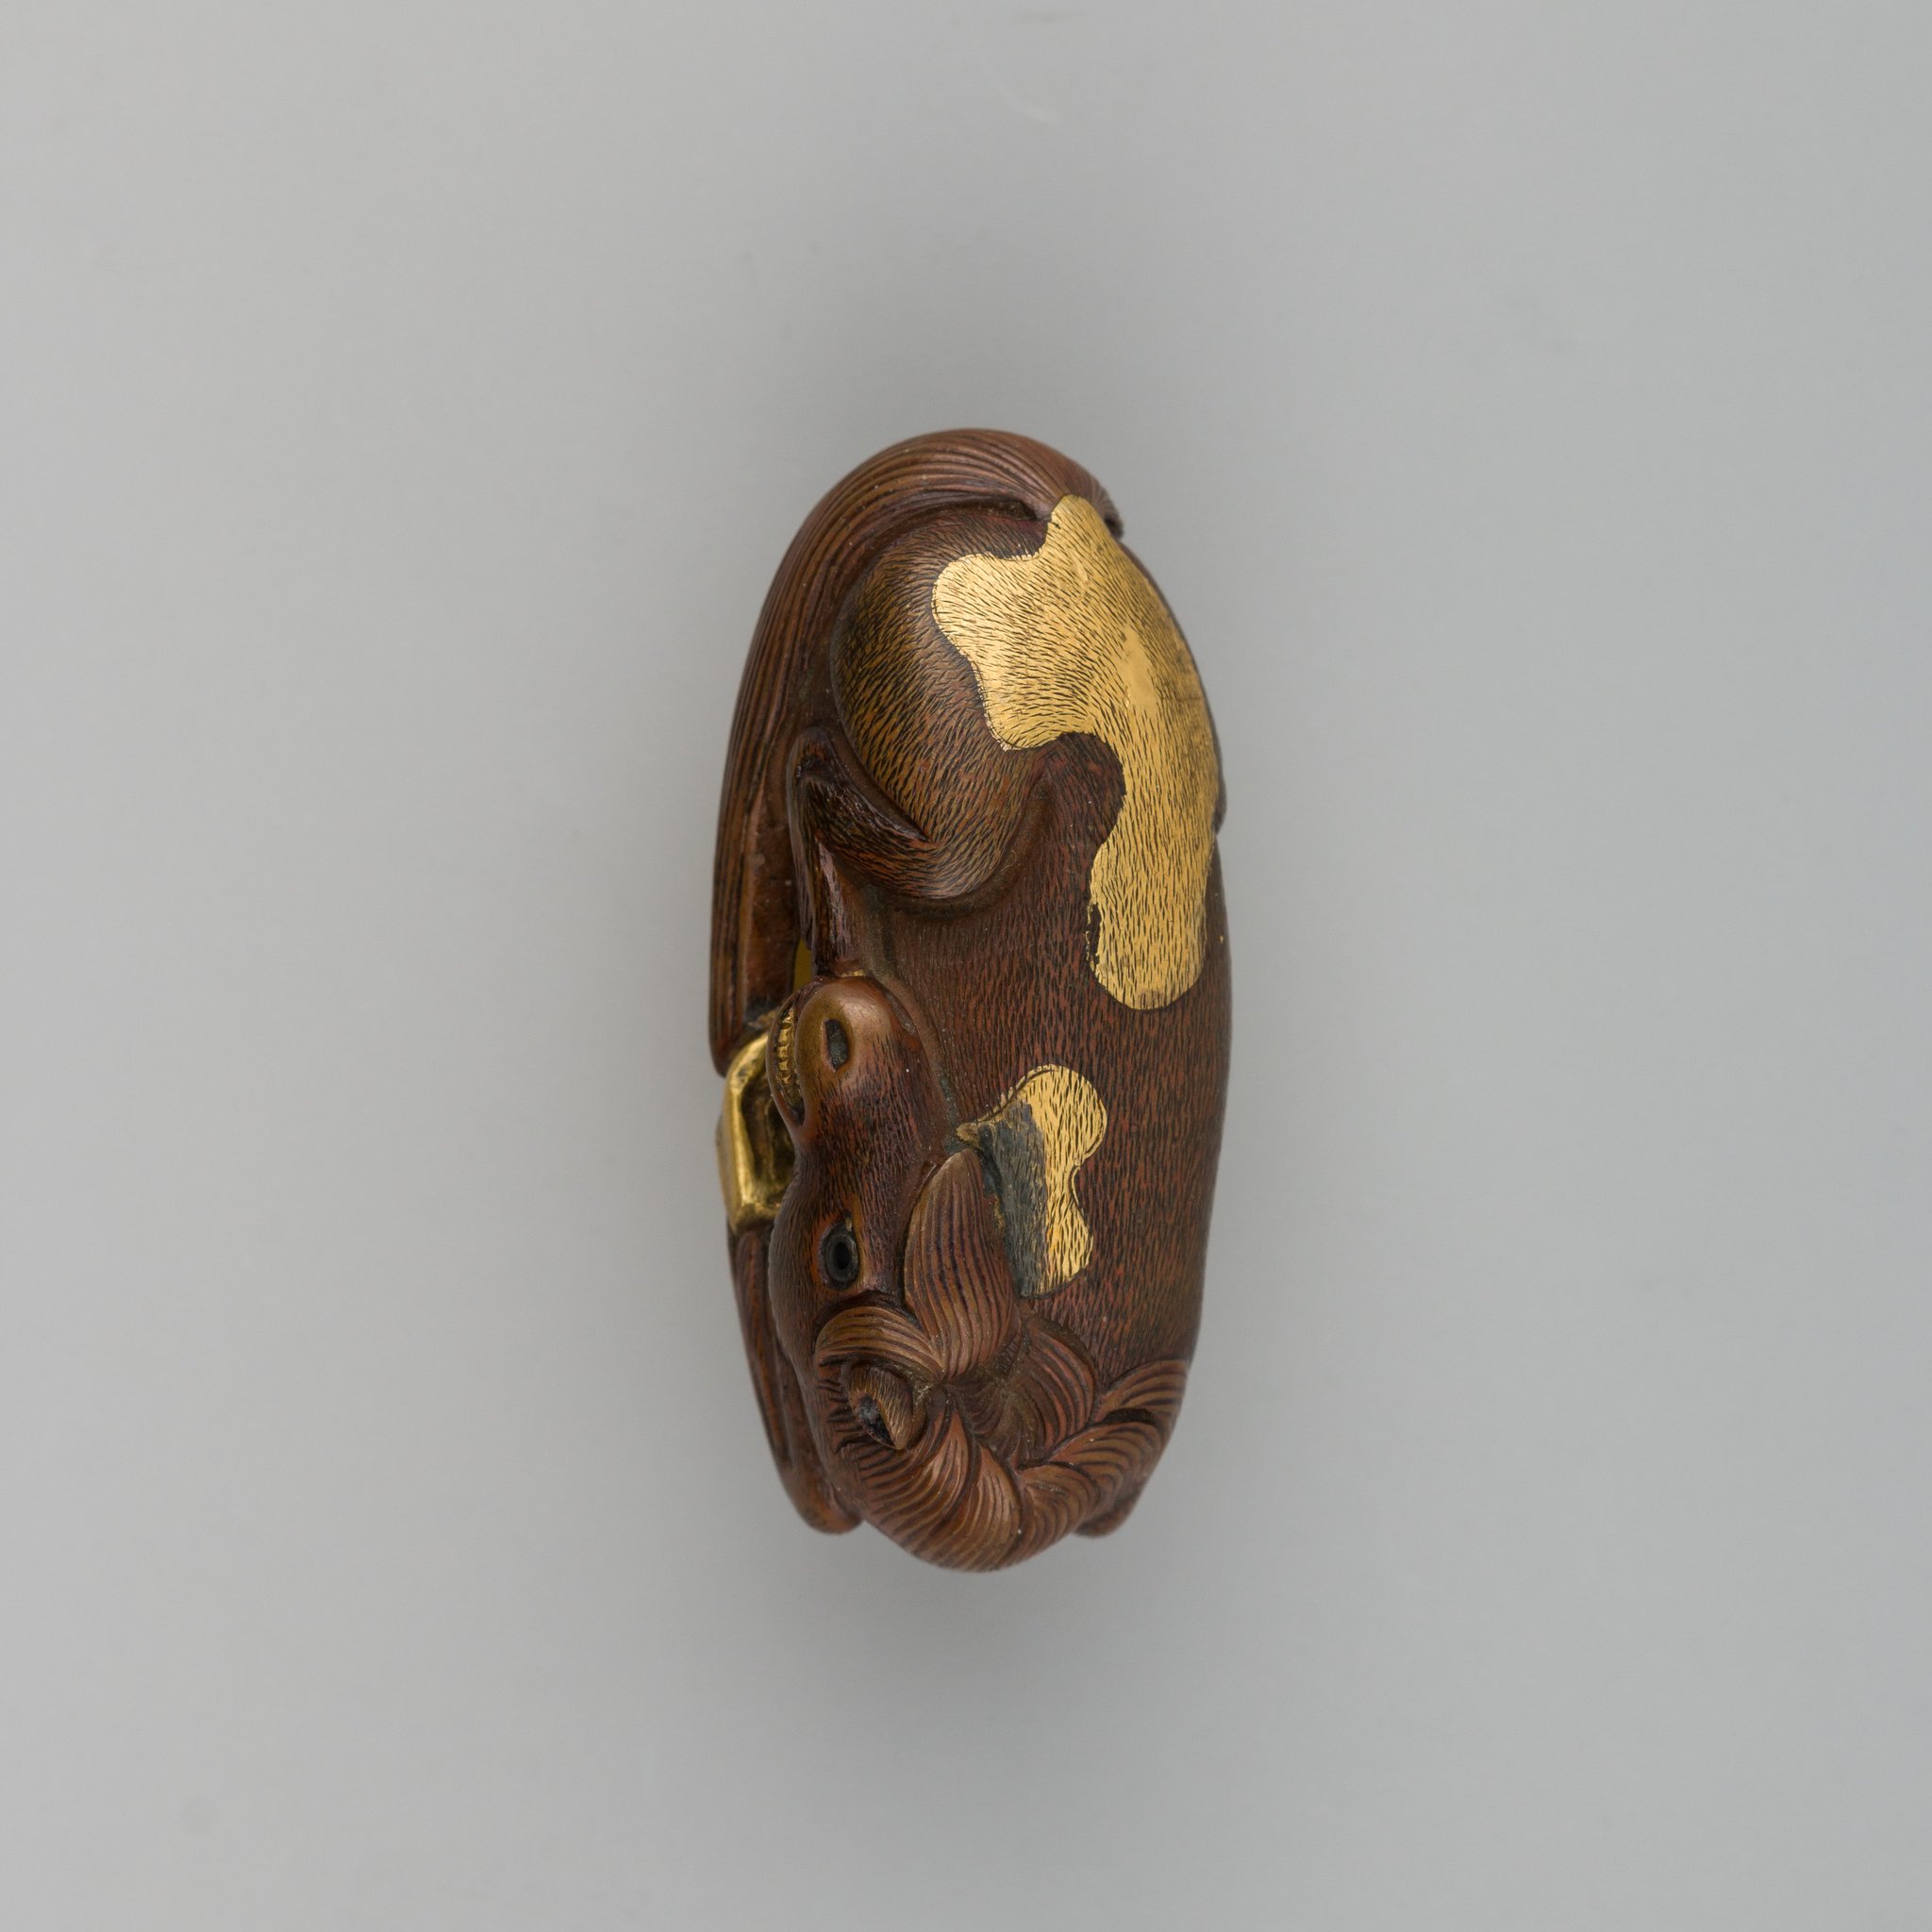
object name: sword pommel kashira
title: Sword Pommel (Kashira)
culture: japanese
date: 1615-1868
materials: copper, gold alloy, silver alloy, gold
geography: japan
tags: animals